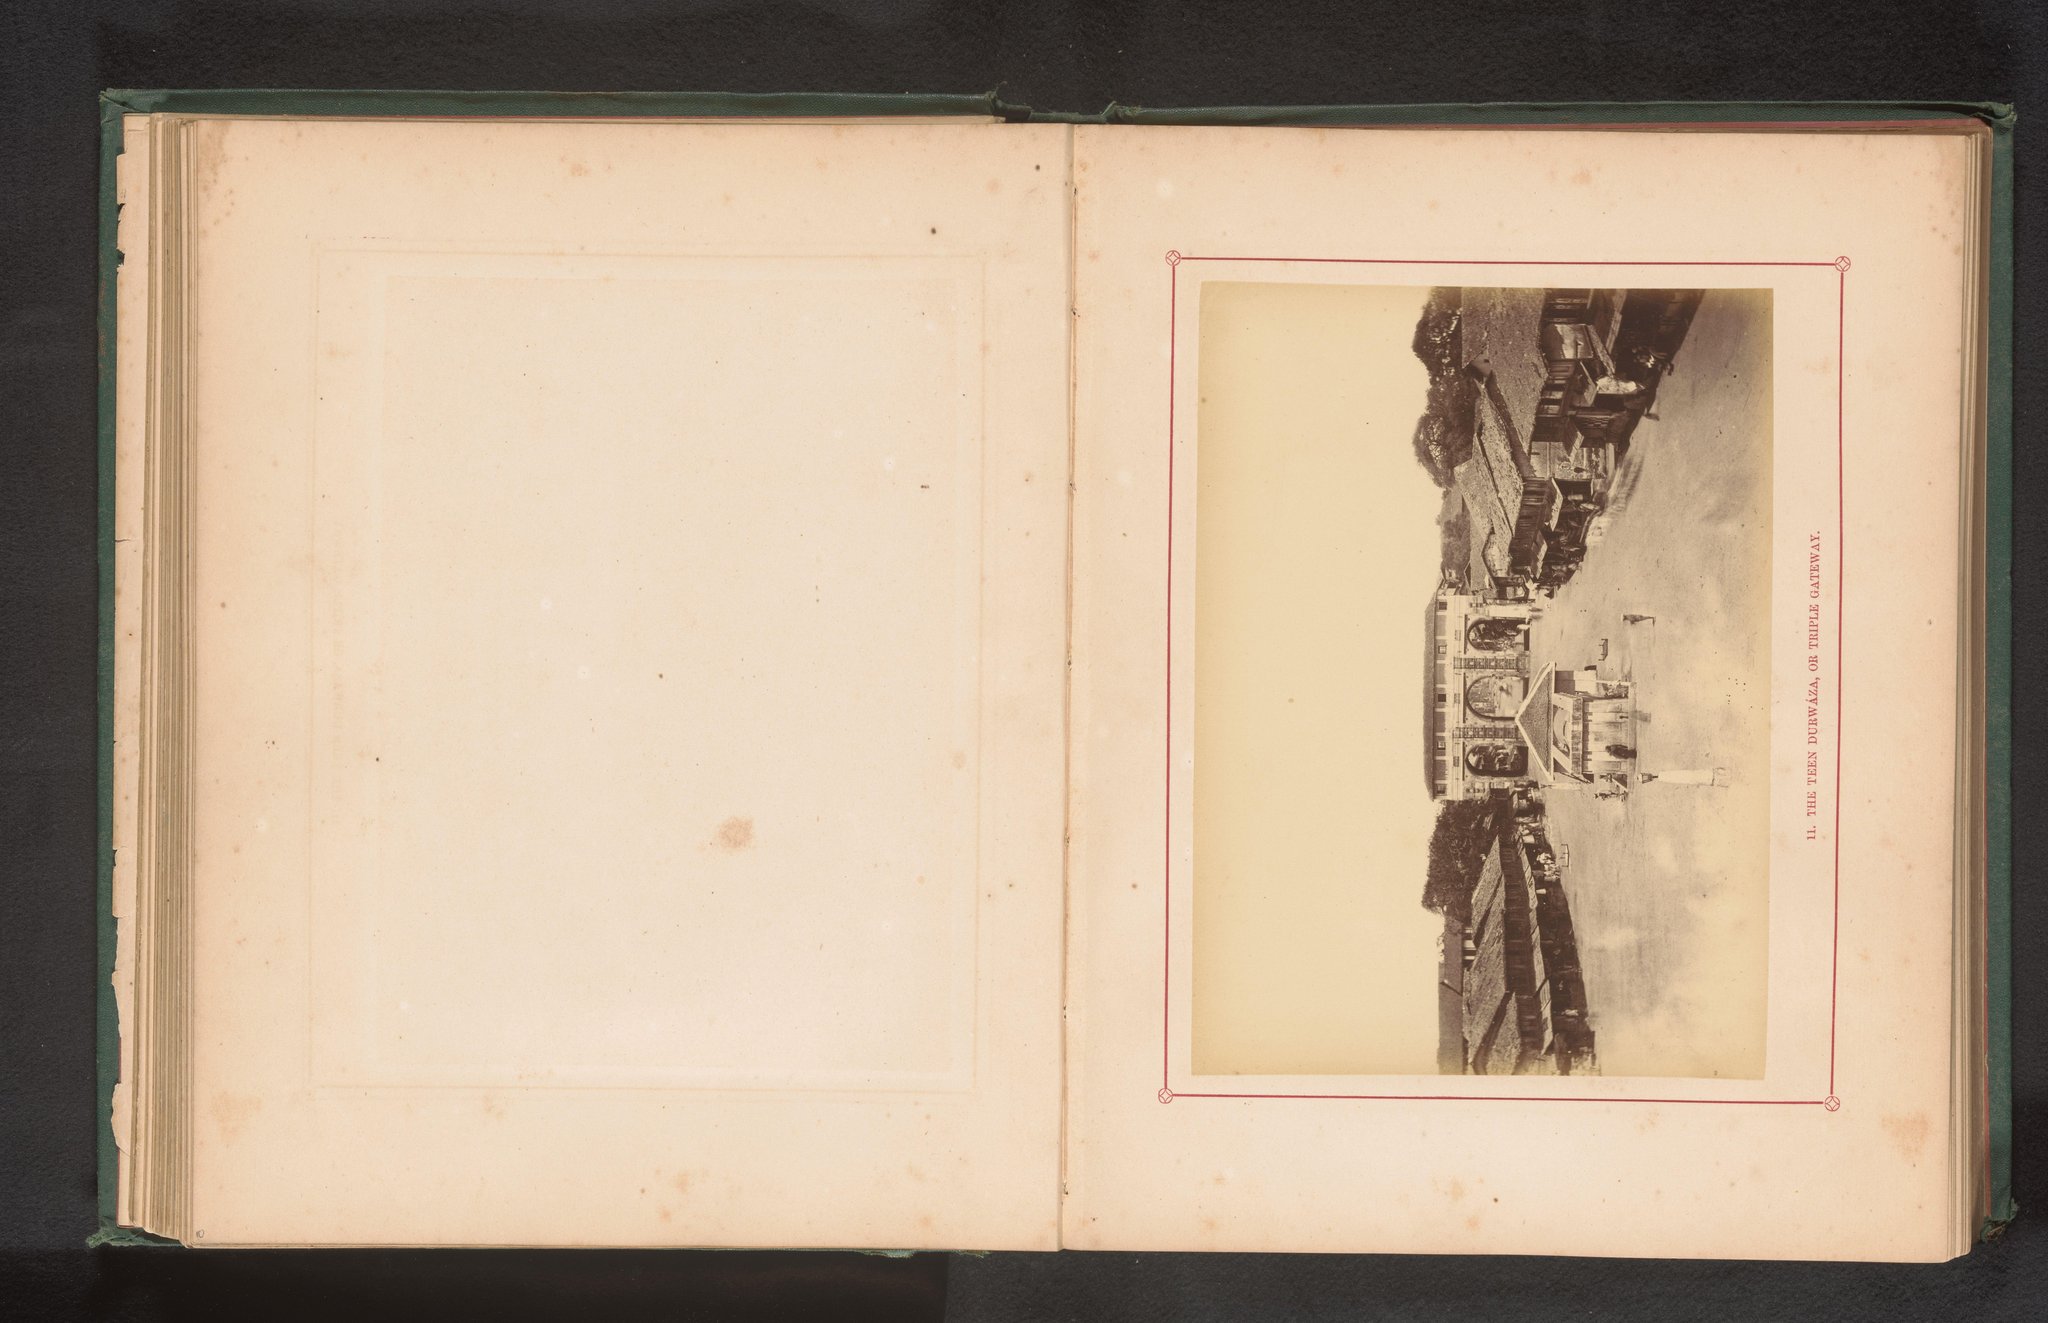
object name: photograph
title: Gezicht op de Teen Darwaza, een poort in Ahmedabad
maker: thomas biggs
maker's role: fotograaf, kapitein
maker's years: 1822-1905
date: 1856-1866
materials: photographic support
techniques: albumen print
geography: ahmedabad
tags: gate ~ fortified city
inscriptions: number: ‘11.’